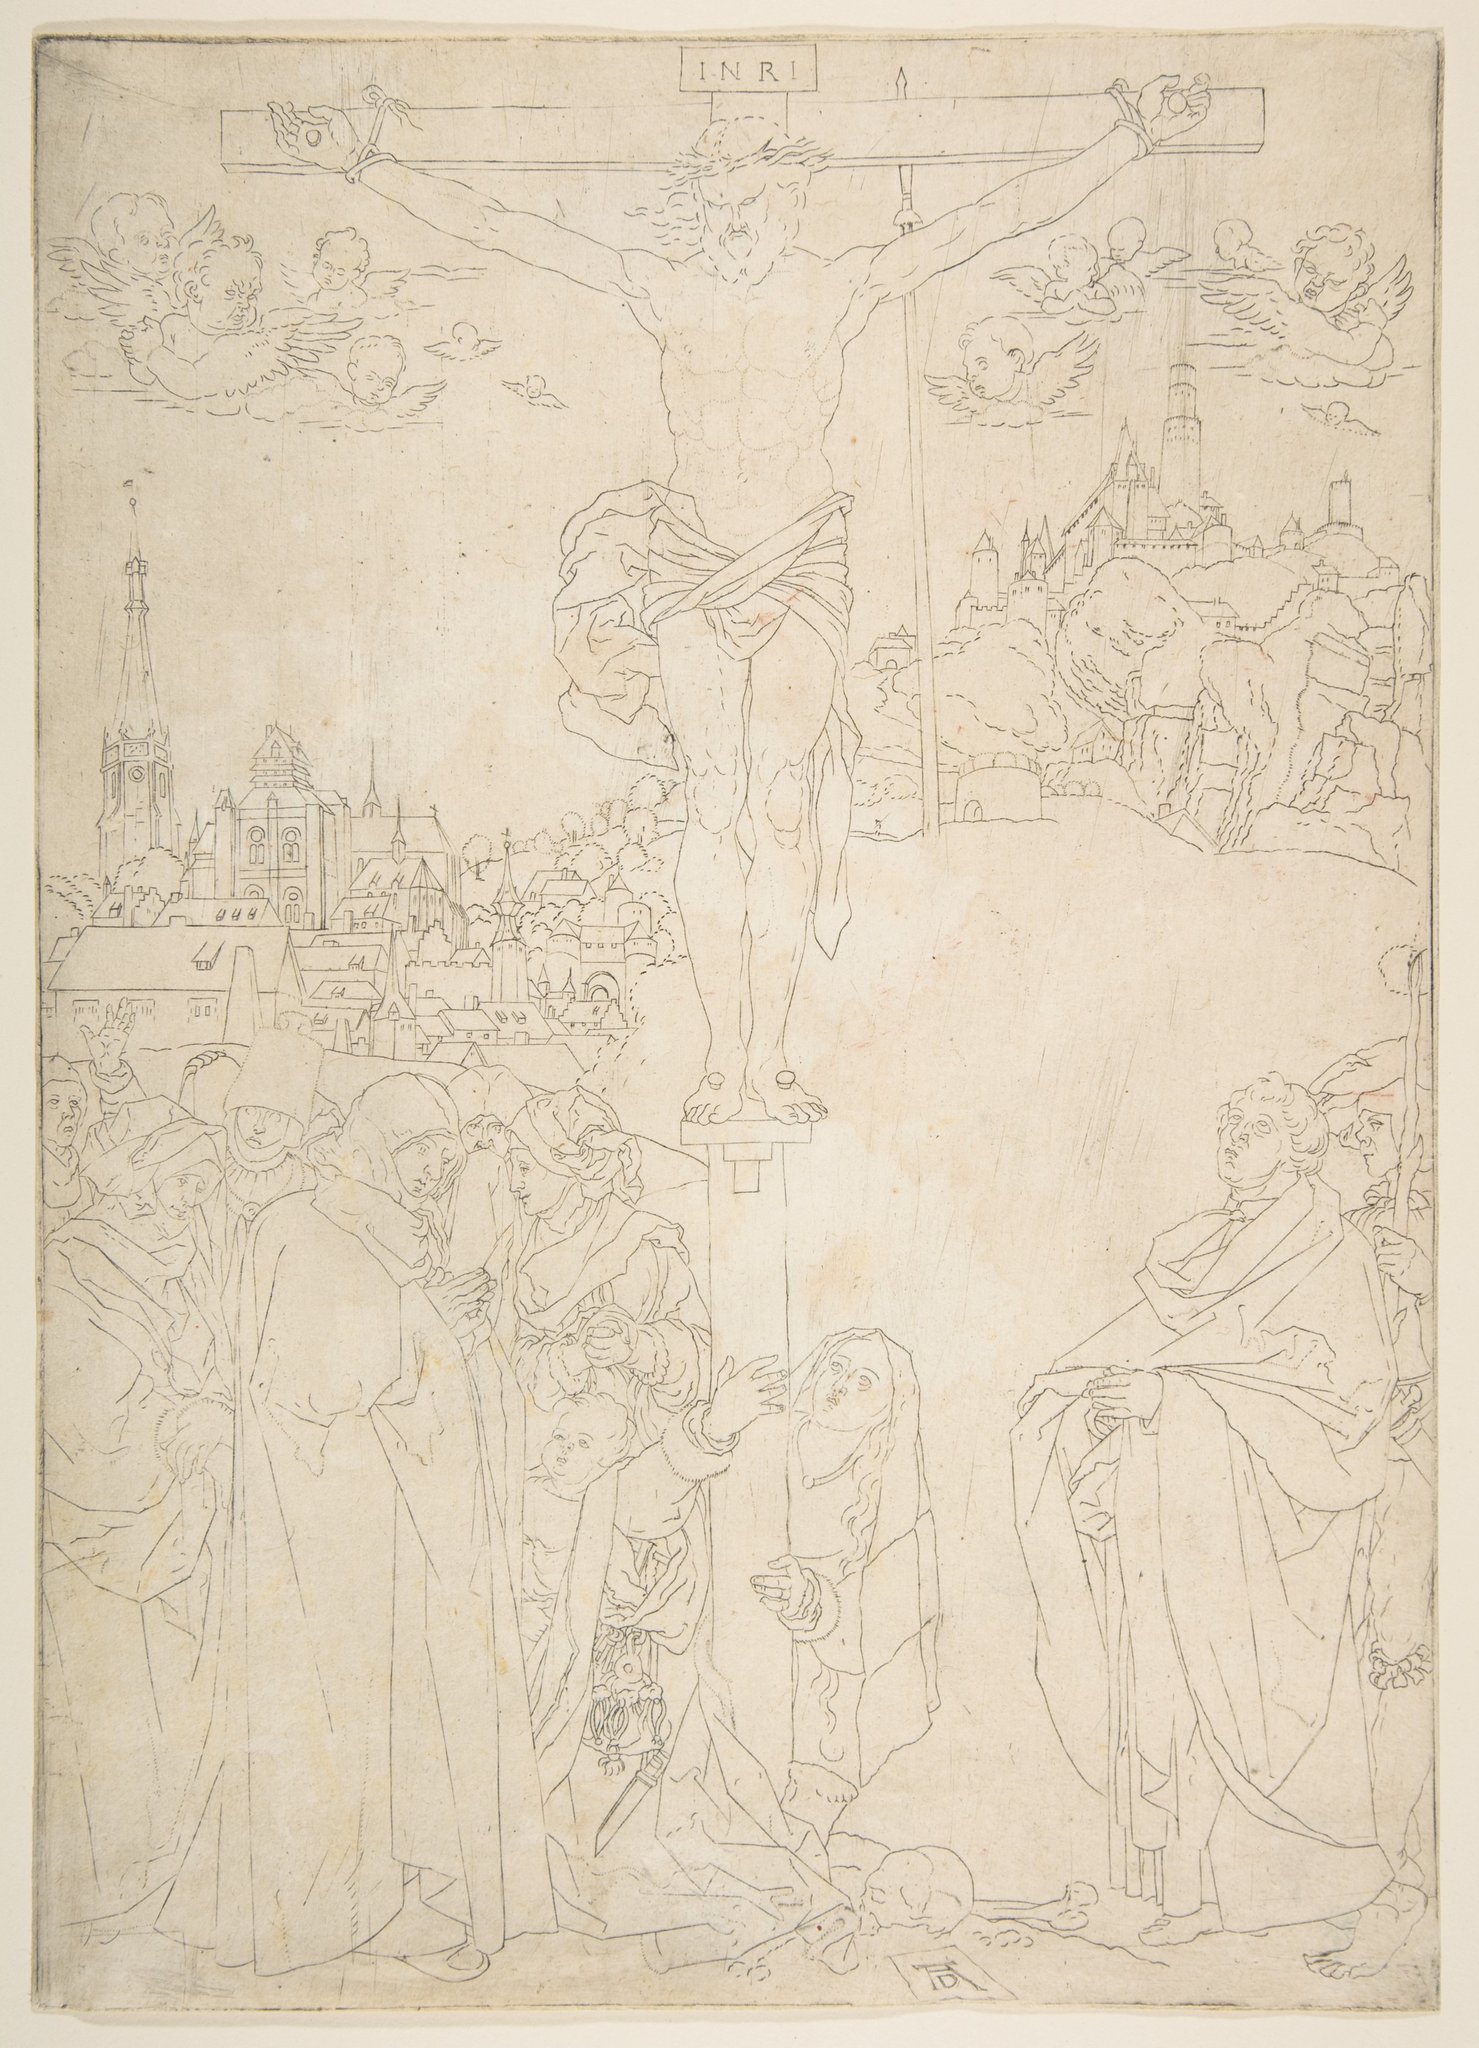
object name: print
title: The Crucifixion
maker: albrecht dürer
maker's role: artist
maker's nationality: german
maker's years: 1471-1528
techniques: engraving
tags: men,women,christ,crucifixion